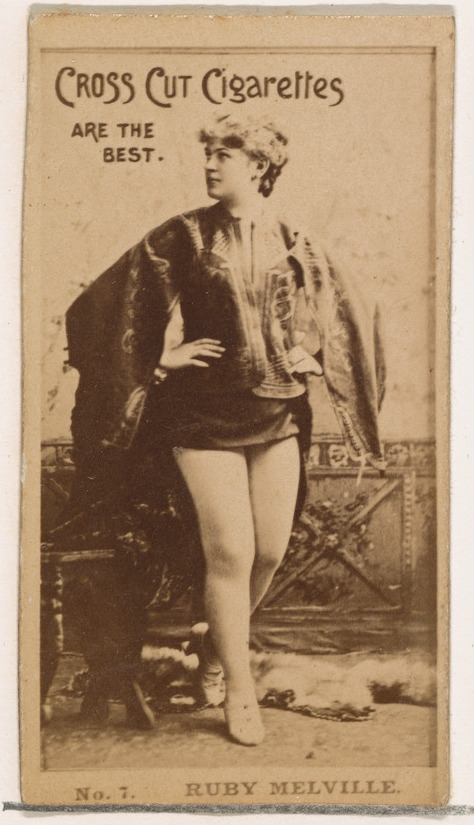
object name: print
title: Card Number 7, Ruby Melville, from the Actors and Actresses series (N145-2) issued by Duke Sons & Co. to promote Cross Cut Cigarettes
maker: w. duke, sons & co.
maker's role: publisher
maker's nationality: american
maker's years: 1870-1920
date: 1880-1889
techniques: albumen silver print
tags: profiles,women,actresses